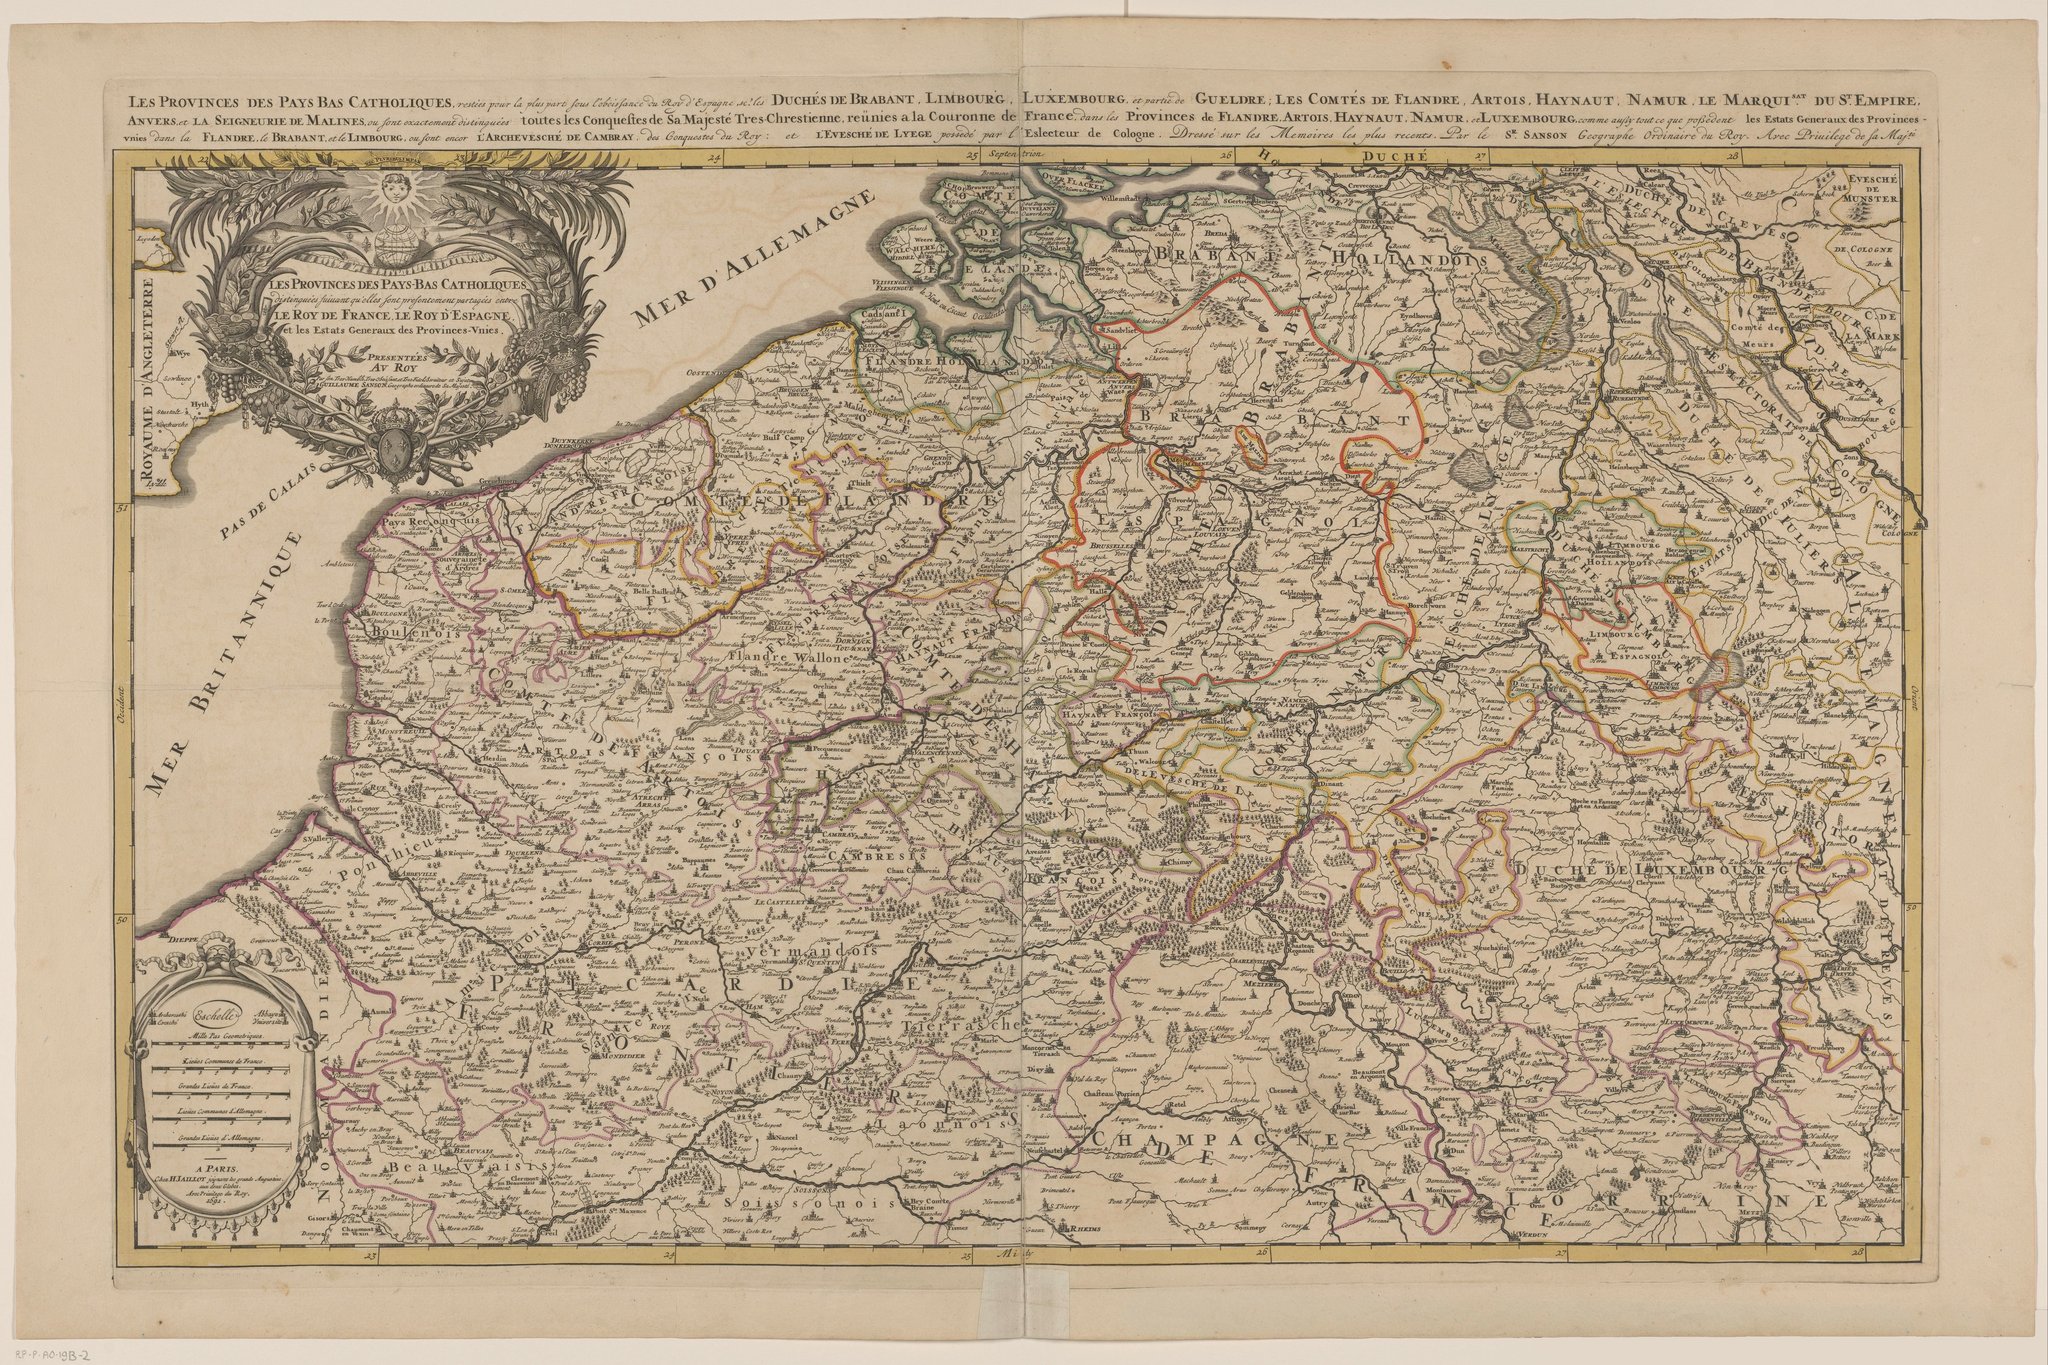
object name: print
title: Les provinces des Pays-Bas Catholiques distingueés (...) / Les provinces des Pays-Bas Catholiques, restées pour la plus (...)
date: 1691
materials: paper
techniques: engraving, hand coloring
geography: paris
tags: maps of separate countries or regions, armorial bearing, heraldry, southern netherlands, belgium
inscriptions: date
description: Kaart van de Zuidelijke Nederlanden. Boven de kaart een titel. Linksboven een cartouche met tweede titel en opdracht, rijkelijk versierd, met onderin het wapen van het Koninkrijk Frankrijk. Linksonder een cartouche met legenda en vijf schaalstokken: 20 Mille Pas Geometriques / 8 Lieües Communes de France / 7 Grandes Lieües de France en twee andere. De kaart is voorzien van een gradenverdeling langs de randen.